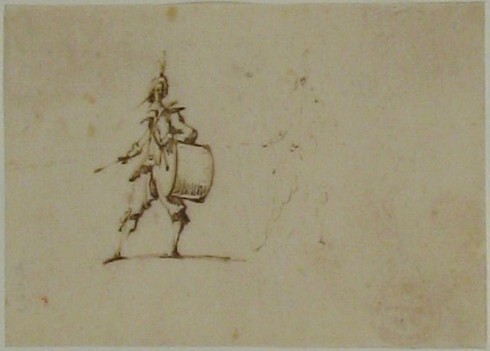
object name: drawing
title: A Drummer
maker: jacques callot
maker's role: artist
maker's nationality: french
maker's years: 1592-1635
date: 1601-1633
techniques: pen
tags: human figures,drums,musicians